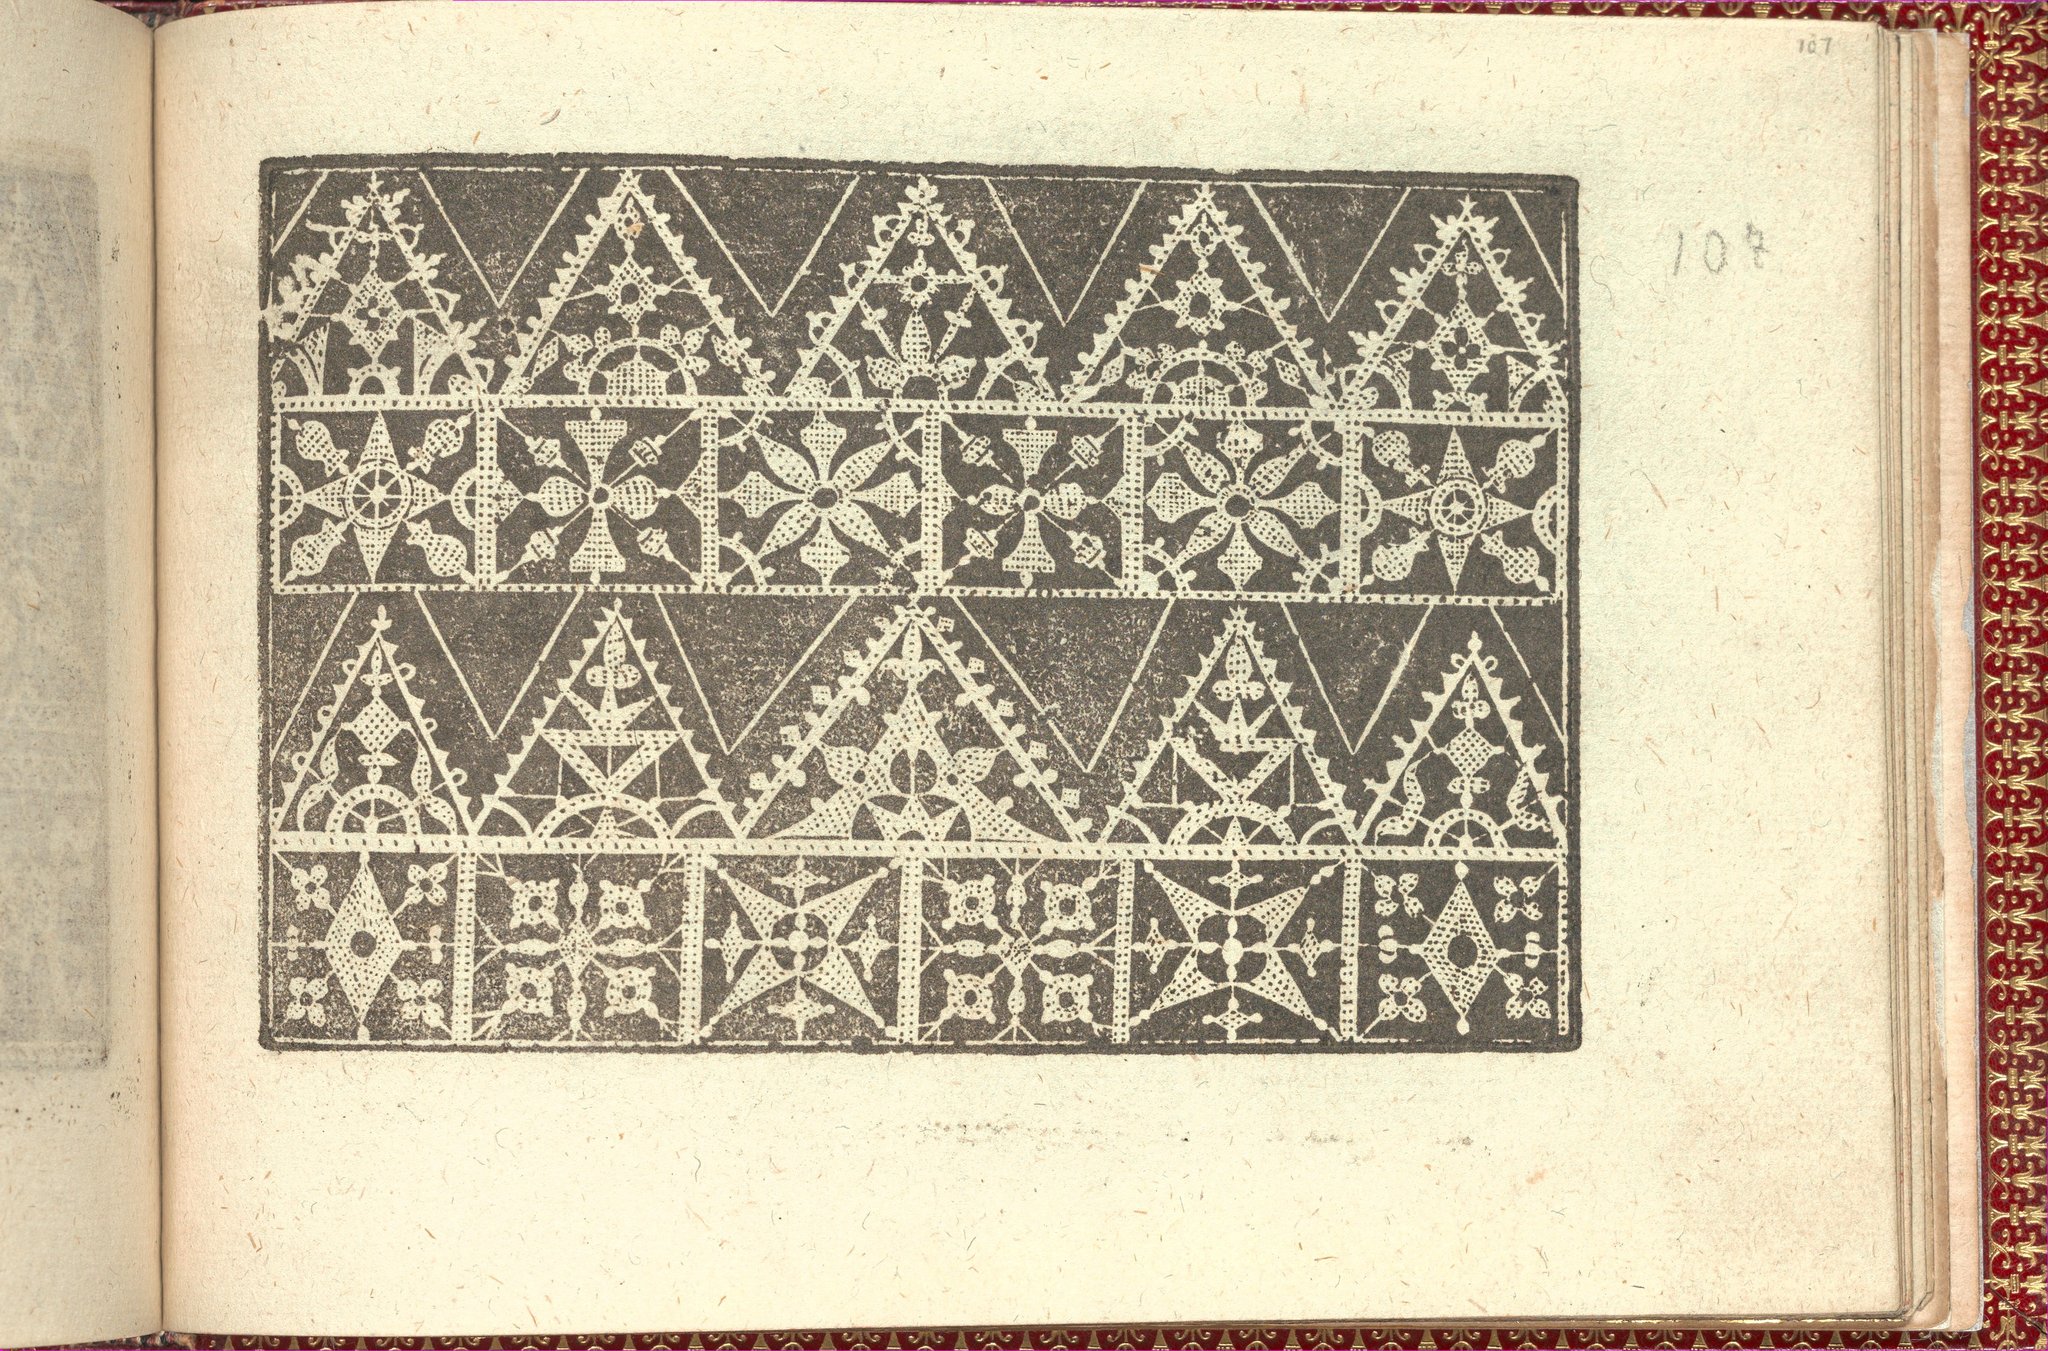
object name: book print ornament architecture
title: Corona delle Nobili et Virtuose Donne: Libro I-IV, page 107 (recto)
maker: cesare vecellio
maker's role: publisher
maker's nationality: italian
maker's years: 1521-1601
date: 1601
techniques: woodcut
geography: italy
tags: ornament